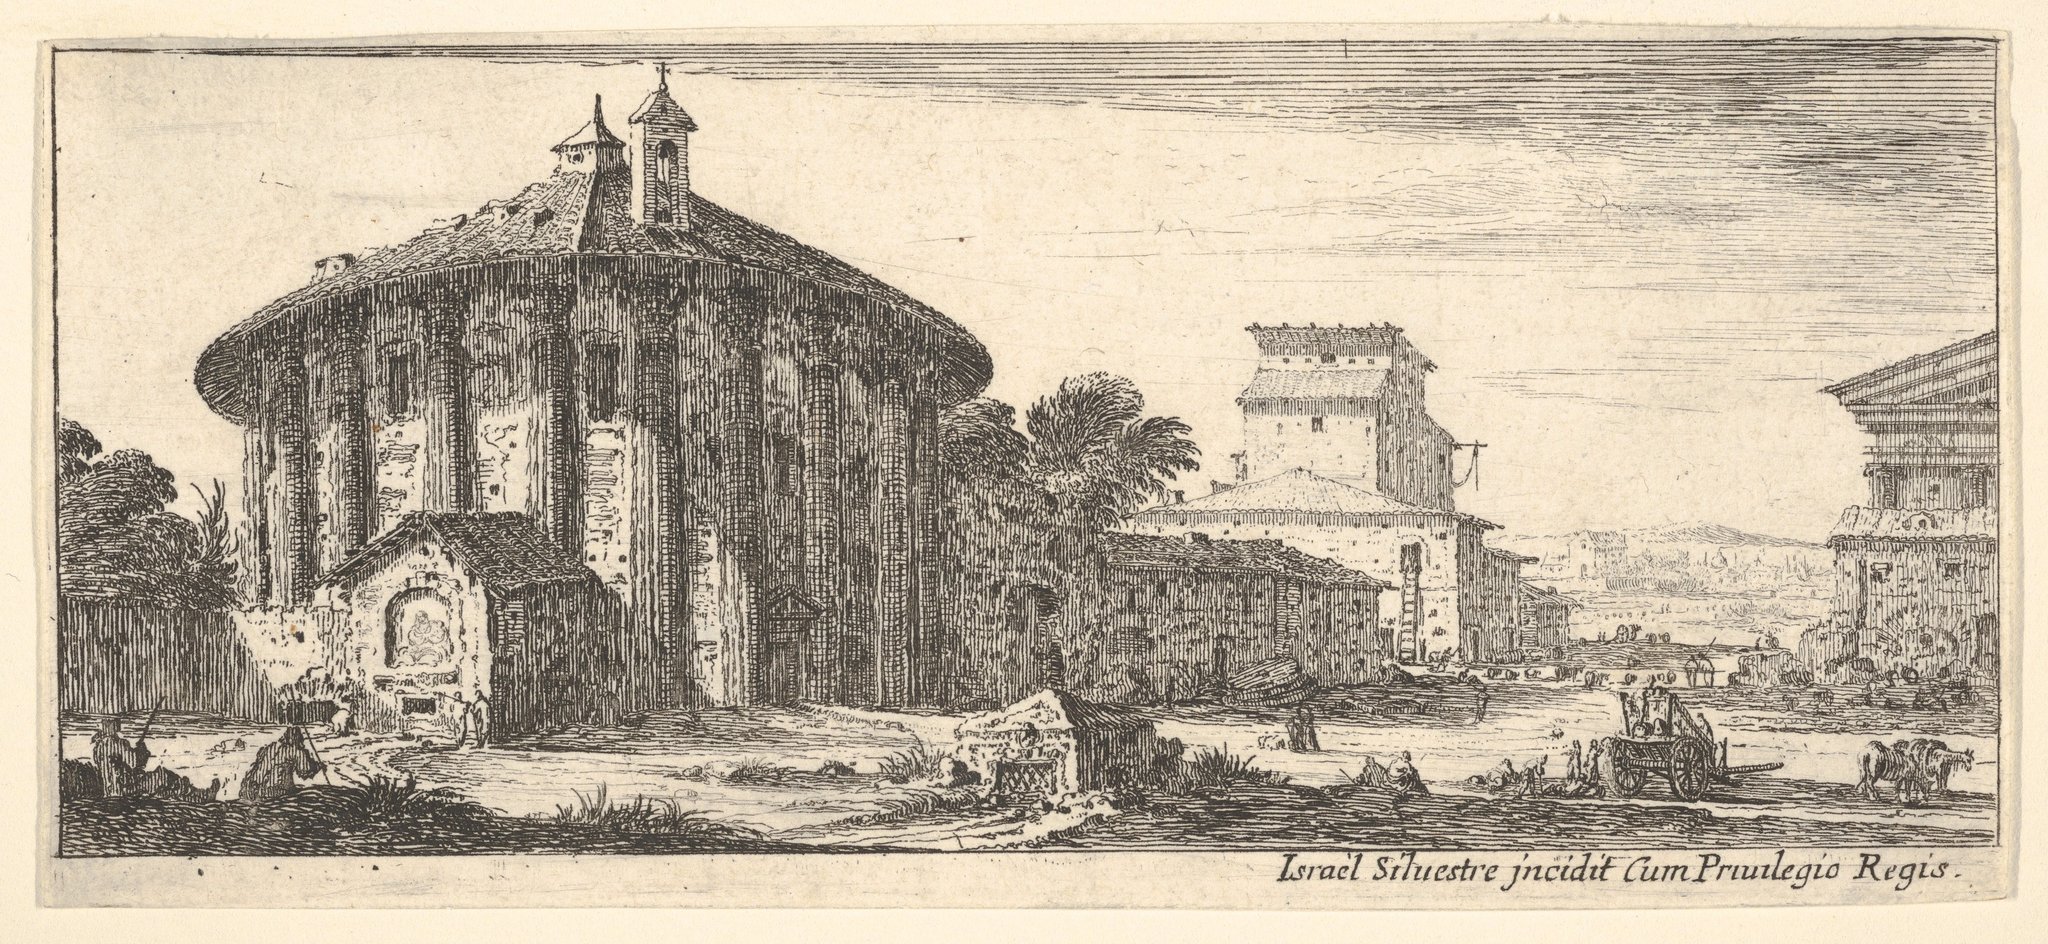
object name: print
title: Tempio del Sole (Temple of Cybele in the Piazza della Bocca della Verità)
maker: israël silvestre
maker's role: artist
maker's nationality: french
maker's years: 1621-1691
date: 1640-1691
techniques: etching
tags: human figures,architecture,buildings